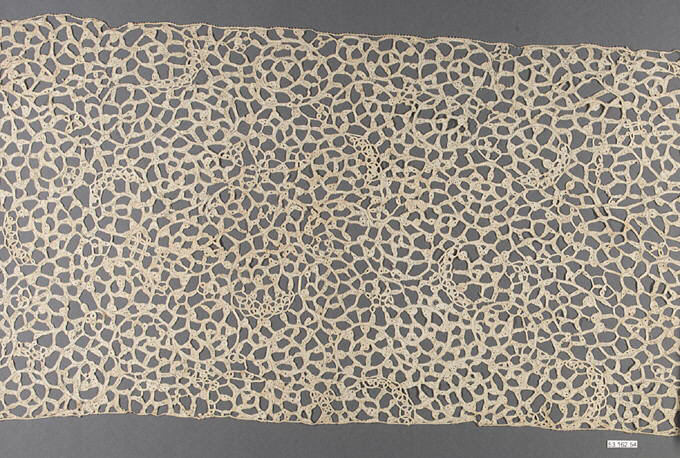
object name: flounce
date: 1601-1700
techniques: lace